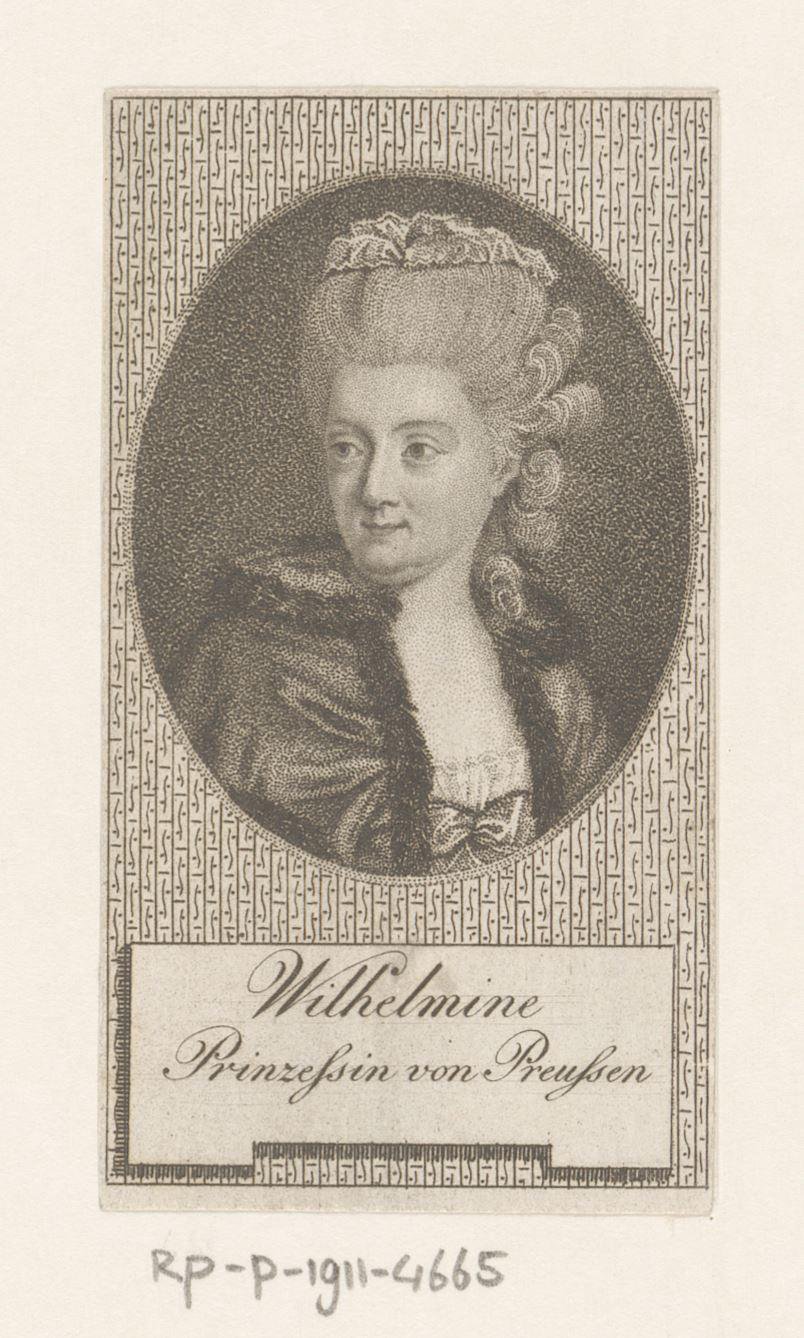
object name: print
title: Portret van Friederike Sophie Wilhelmine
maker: meno haas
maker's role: print maker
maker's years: 1752-1833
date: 1762-1820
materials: paper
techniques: etching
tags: historical persons - bb - woman, princess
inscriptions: collector's mark: Lugt 2228